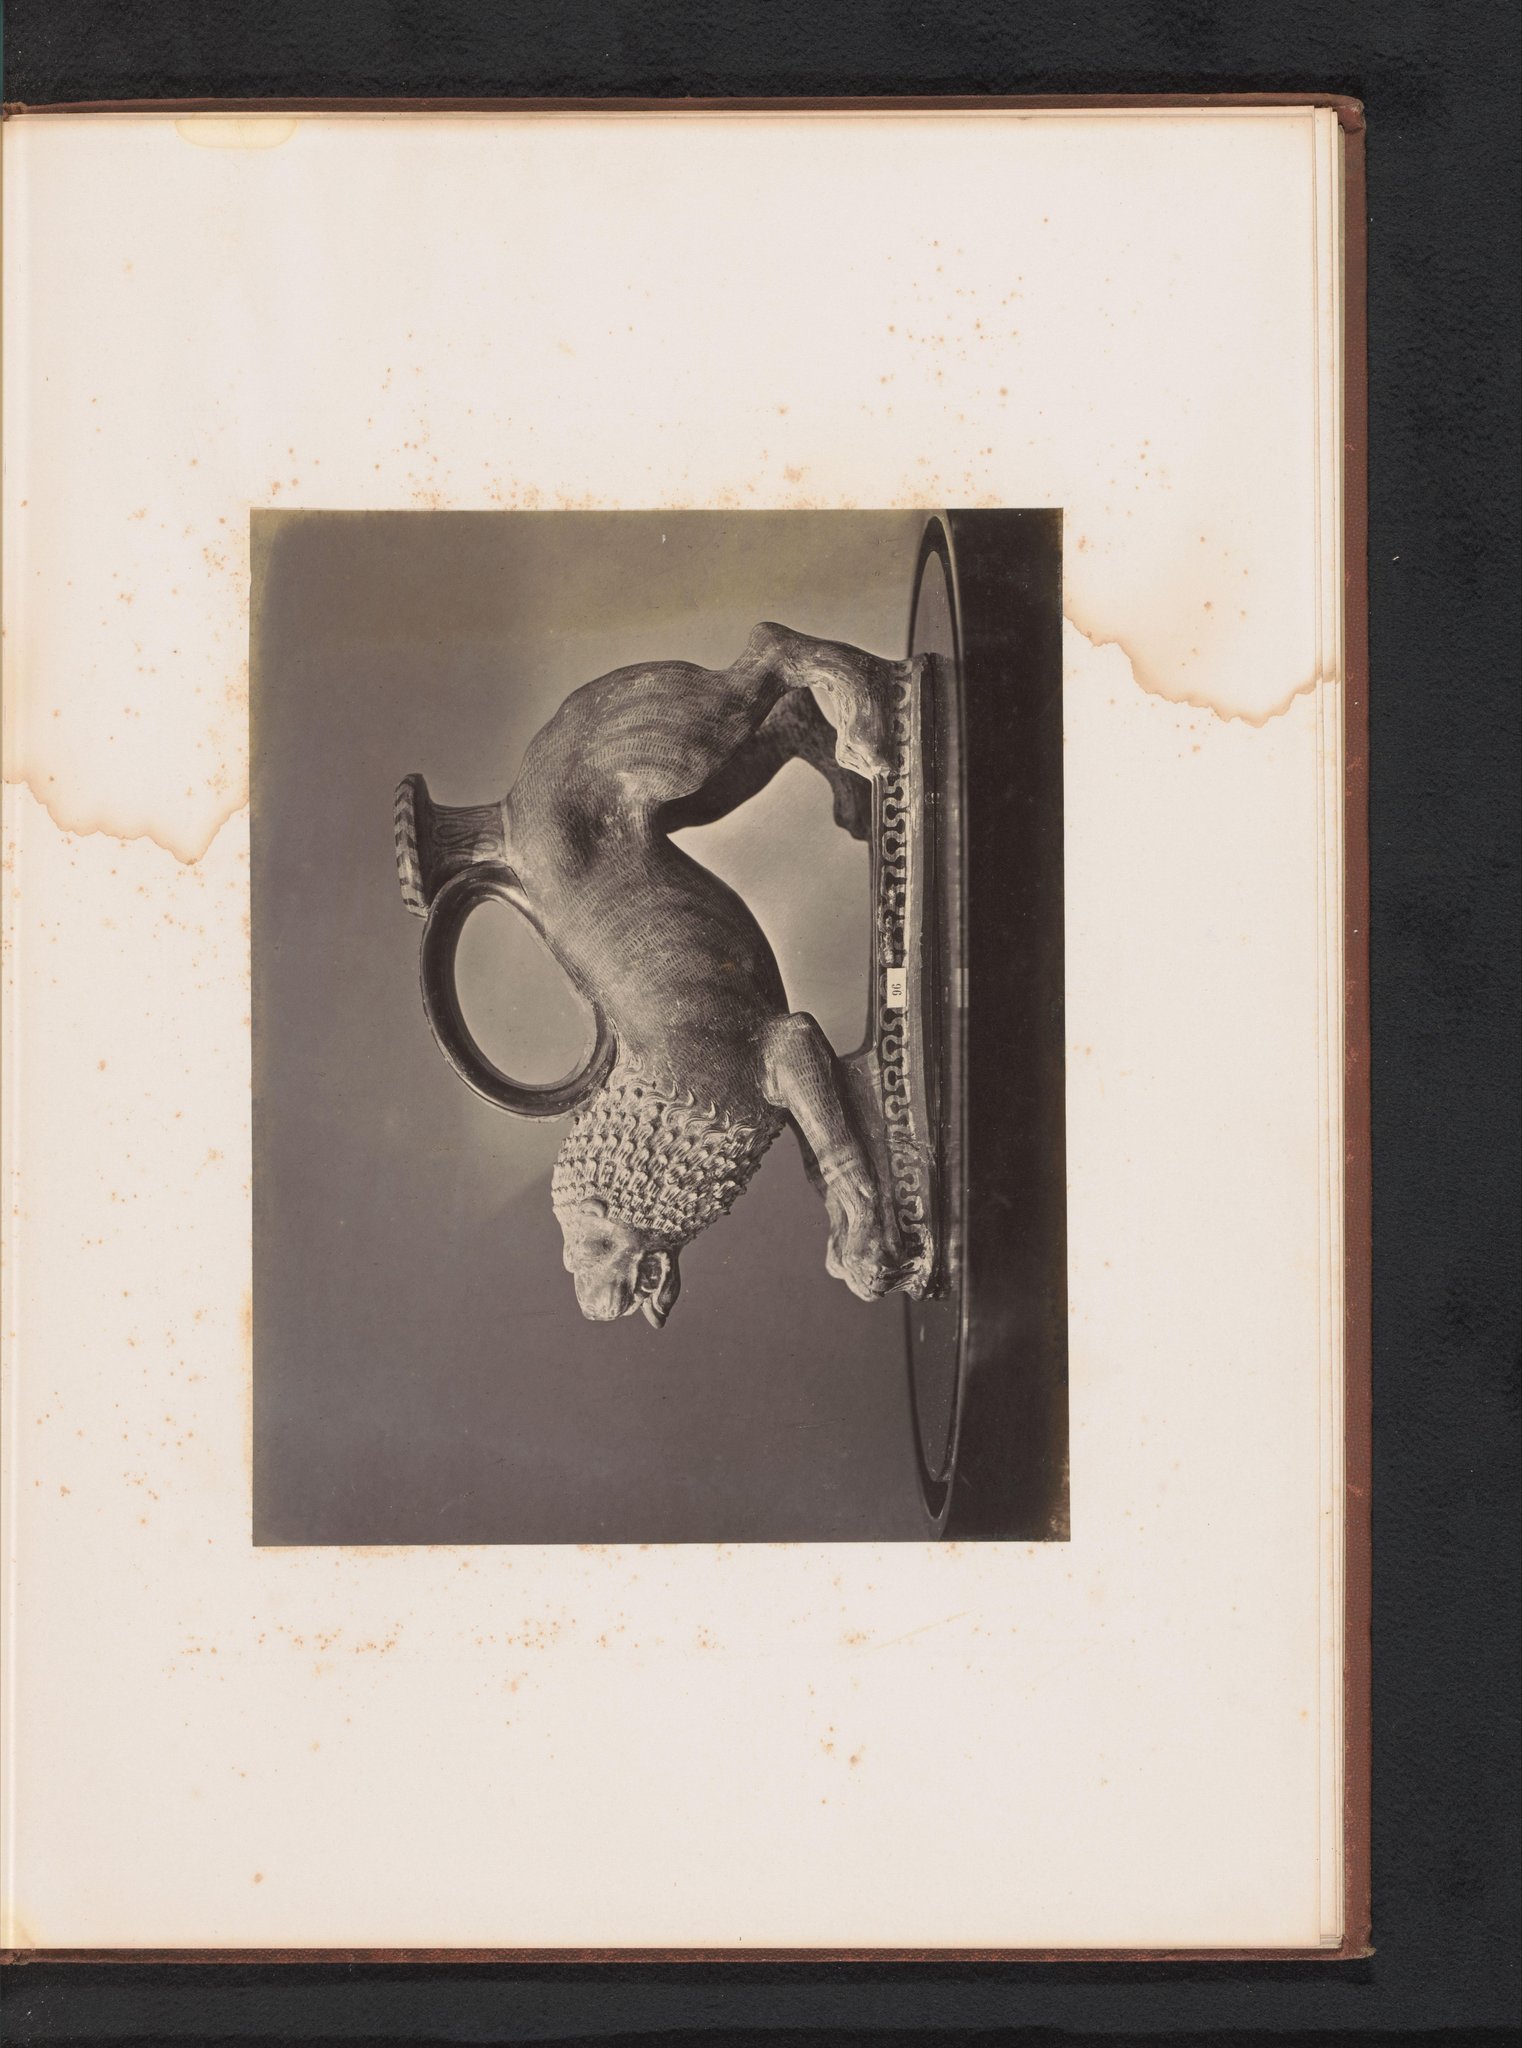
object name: page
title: Drinkbeker van keramiek in de vorm van een leeuw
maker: stephen thompson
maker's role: fotograaf, schrijver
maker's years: 1831-1893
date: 1869-1874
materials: photographic support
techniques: albumen print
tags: container of ceramics: jar, jug, pot, vase, beasts of prey, predatory animals: lion